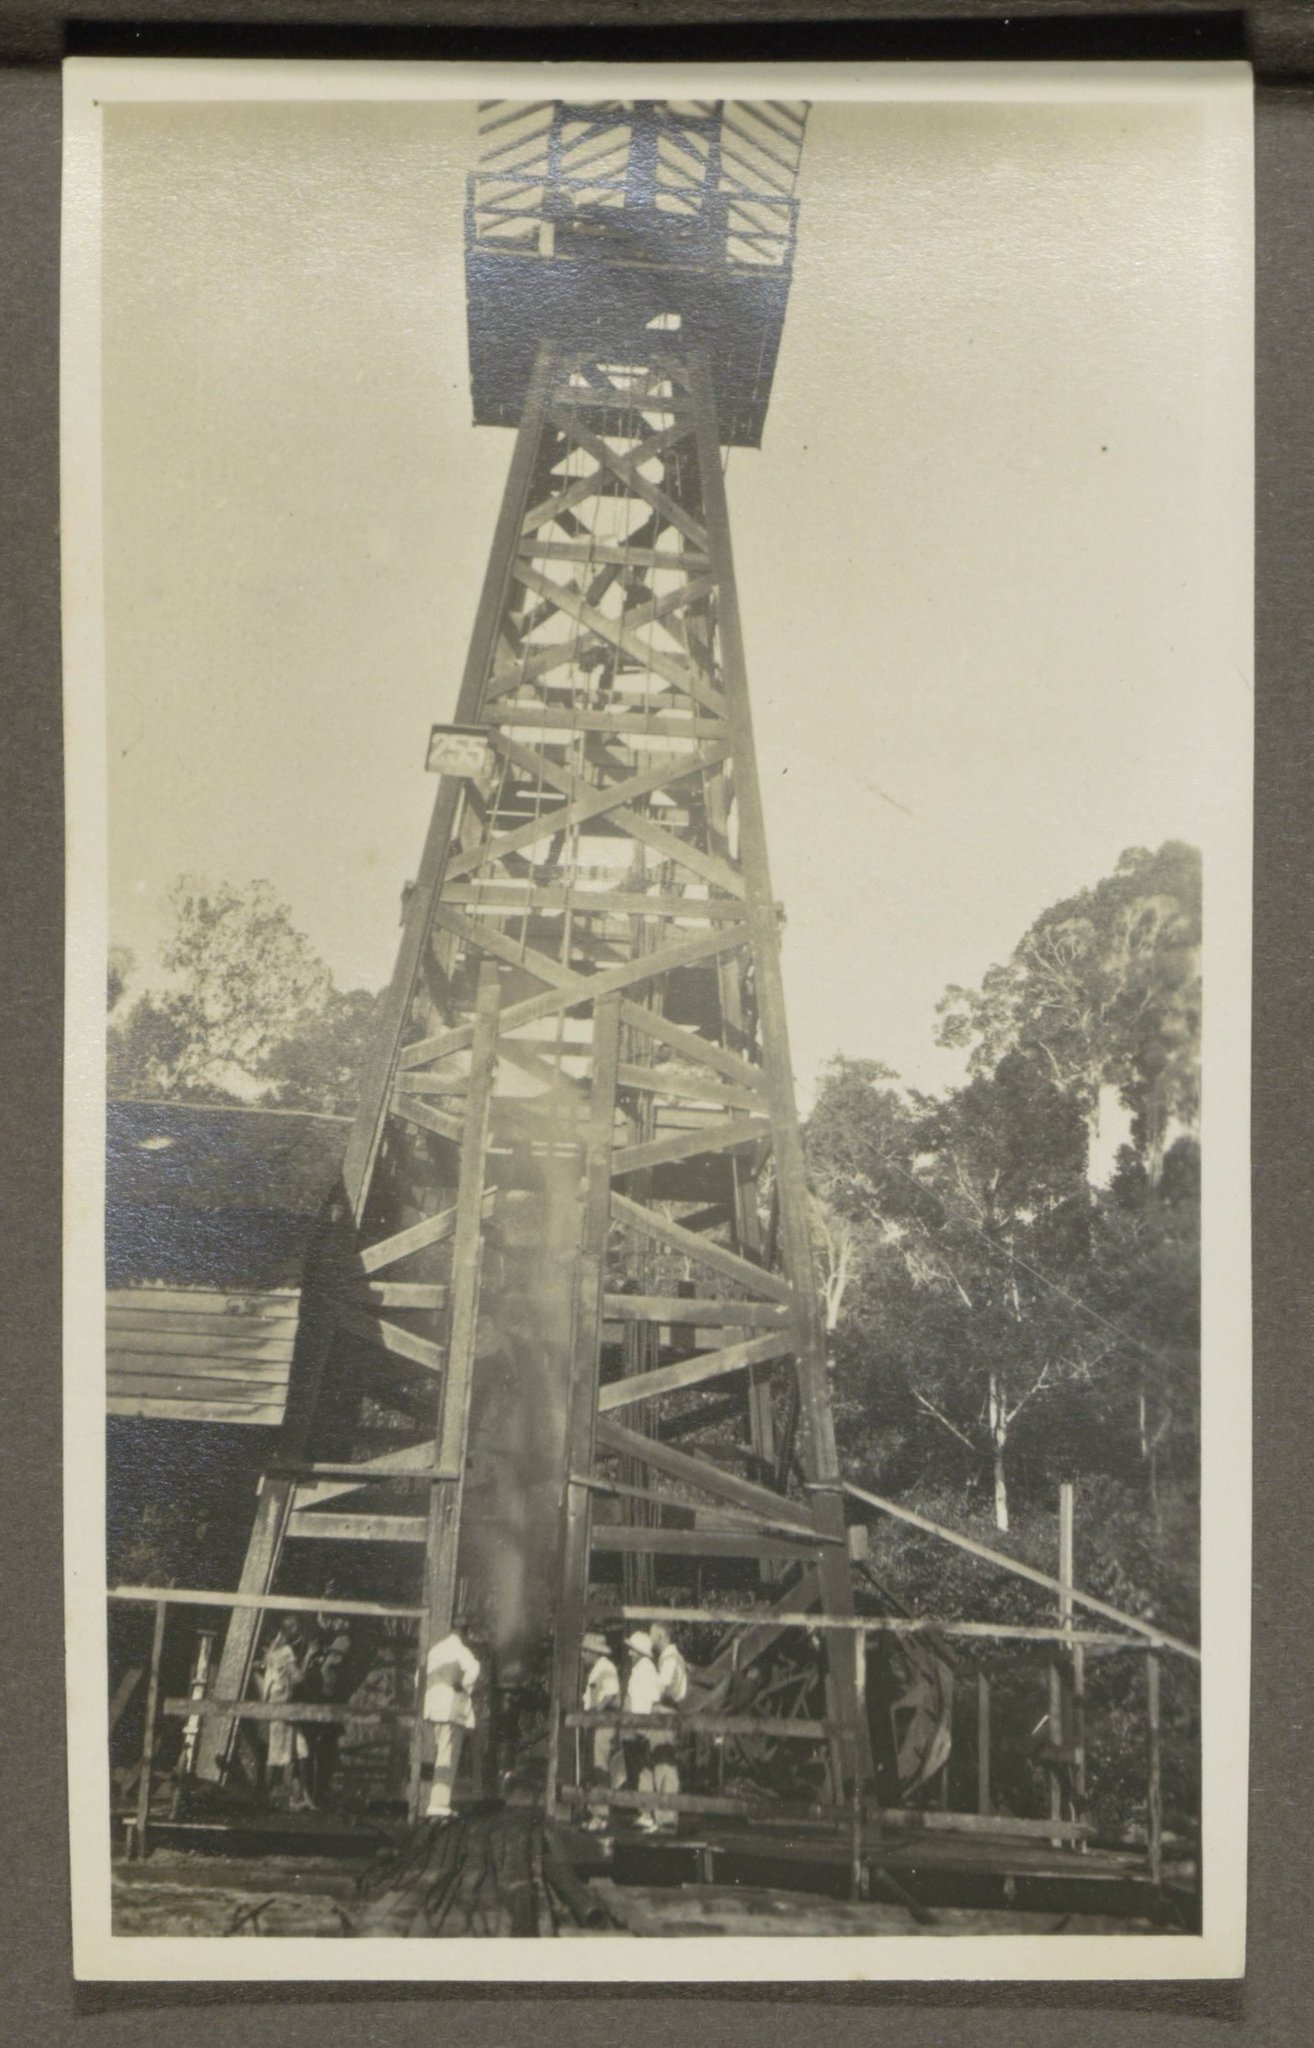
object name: photograph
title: Mannen in tropenkleding aan de voet van een boortoren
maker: Anonymous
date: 1920-1930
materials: photographic support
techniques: gelatin silver print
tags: derrick ~ oil, dutch east indies, the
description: Onderdeel van familiealbum Nederlands-Indië.